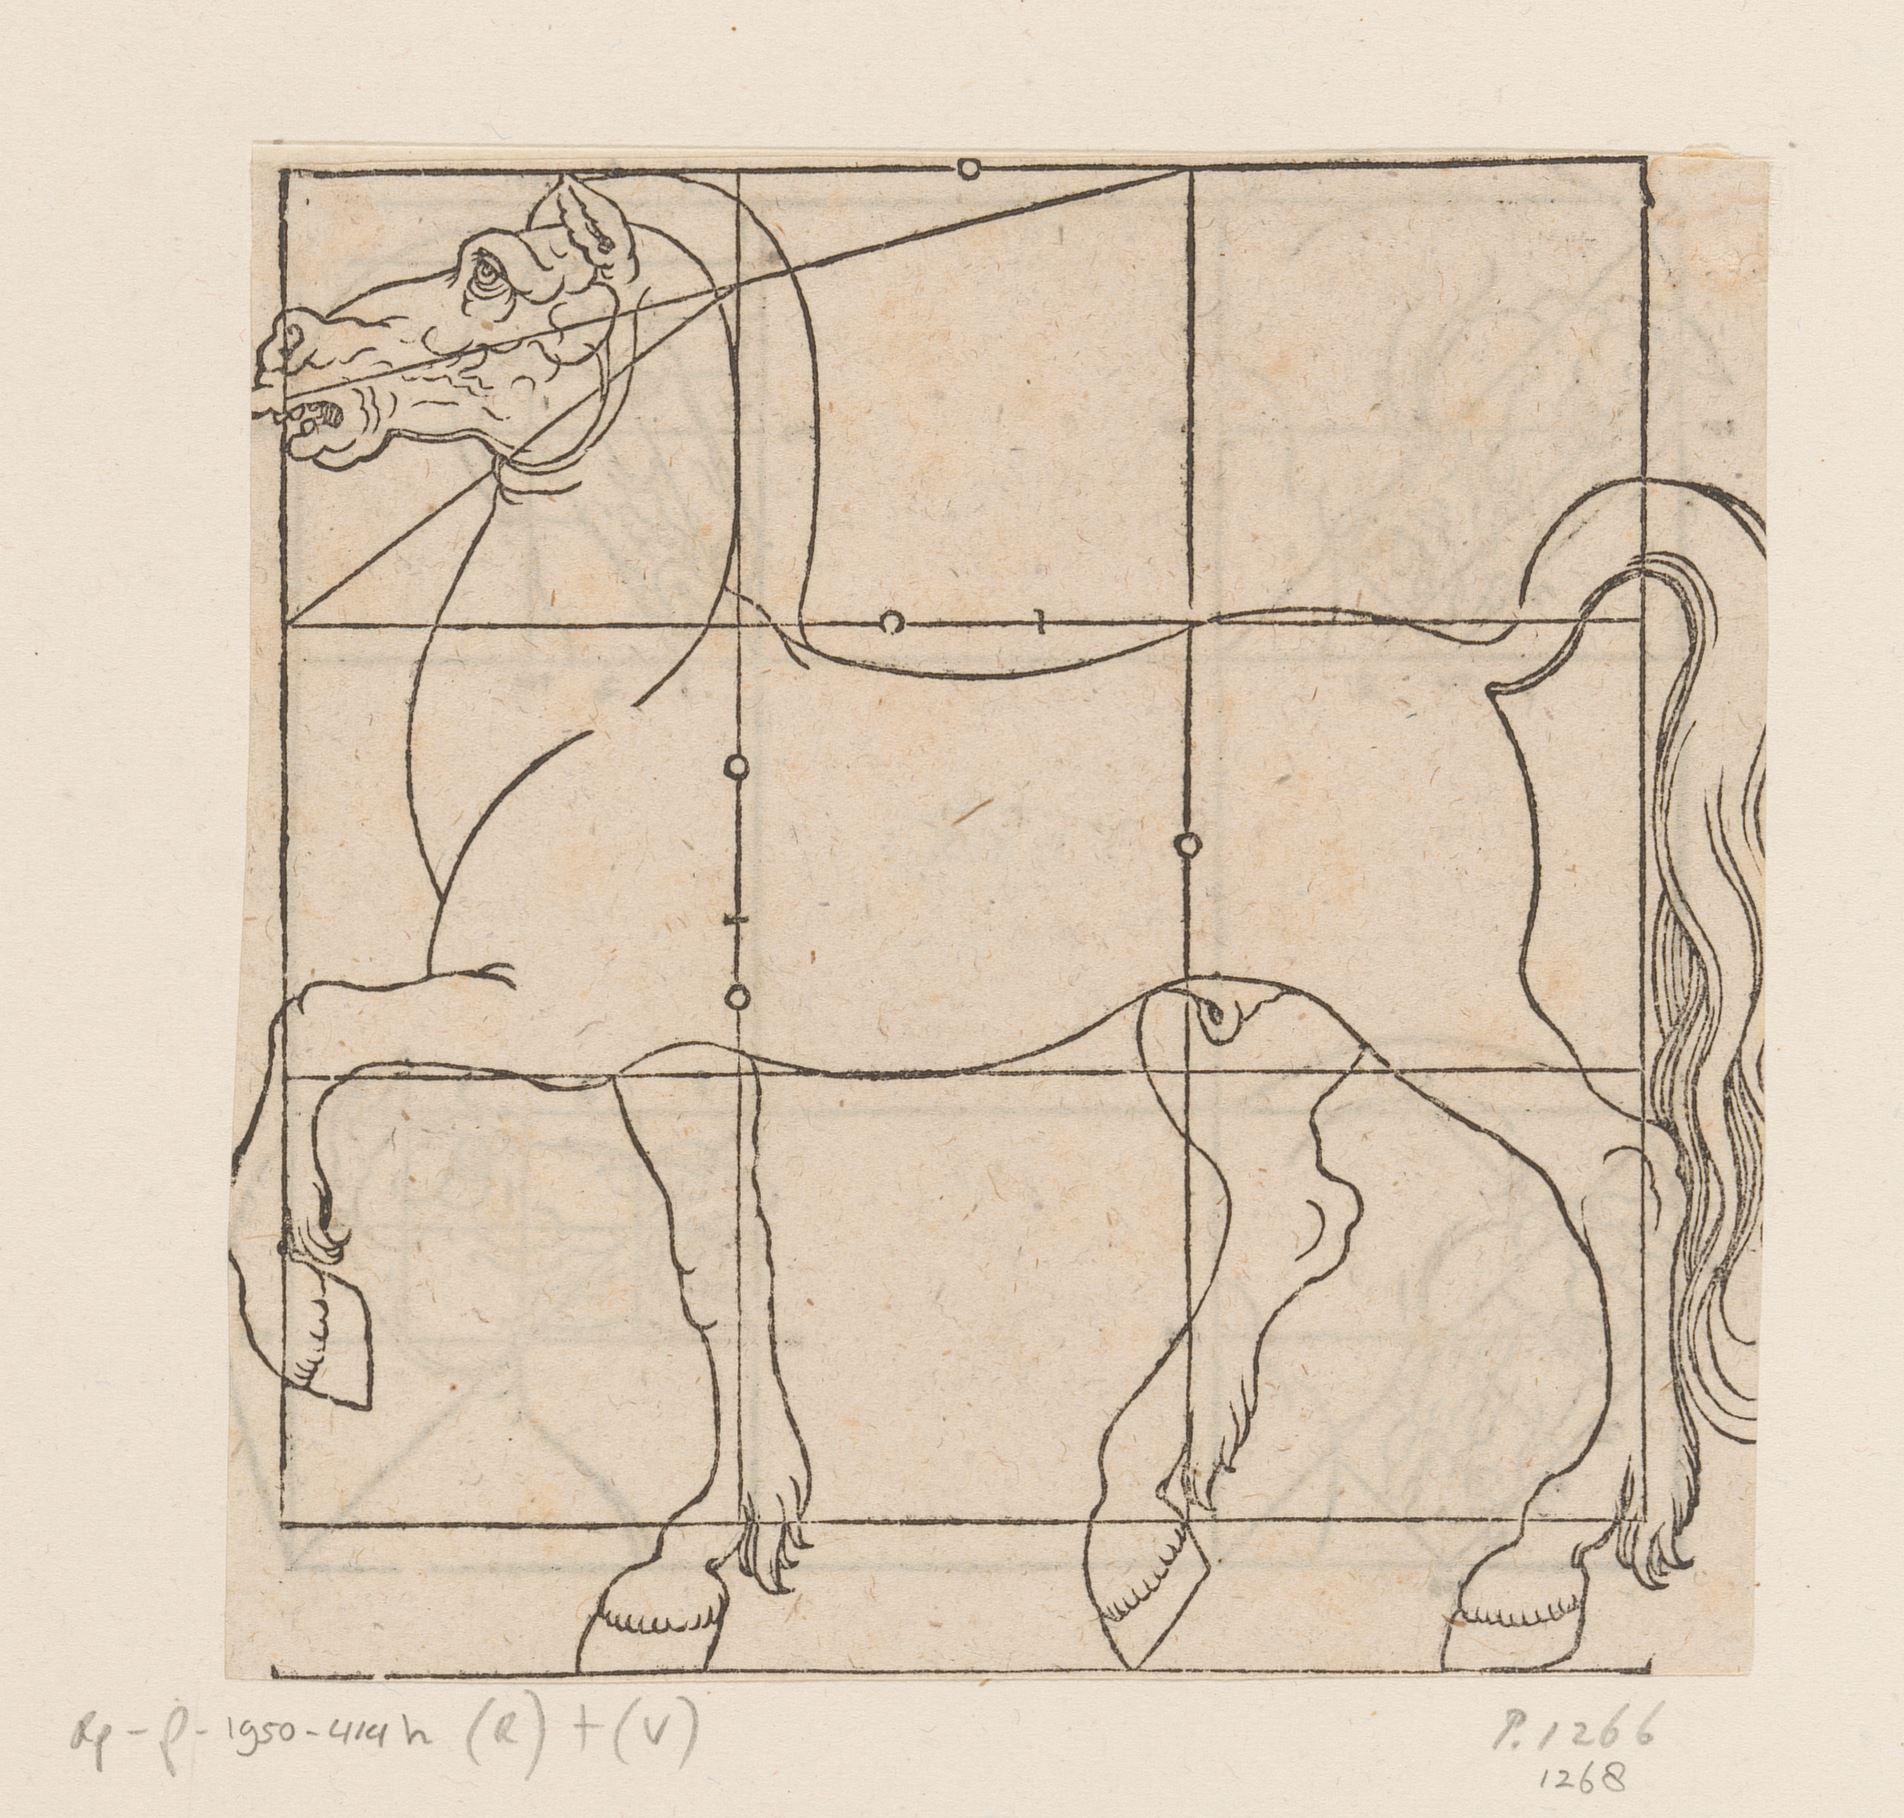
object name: book illustration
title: Model voor een paard met raster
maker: Anonymous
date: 1565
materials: paper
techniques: woodcut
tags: horses and kindred animals, model-books ~ implements of painter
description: Prent afkomstig uit: Beham, Hans Sebald. Sebalden Behems Kunst und Ler Büchlin (...). Frankfurt am Main: erven Christian Egenolff, 1565.